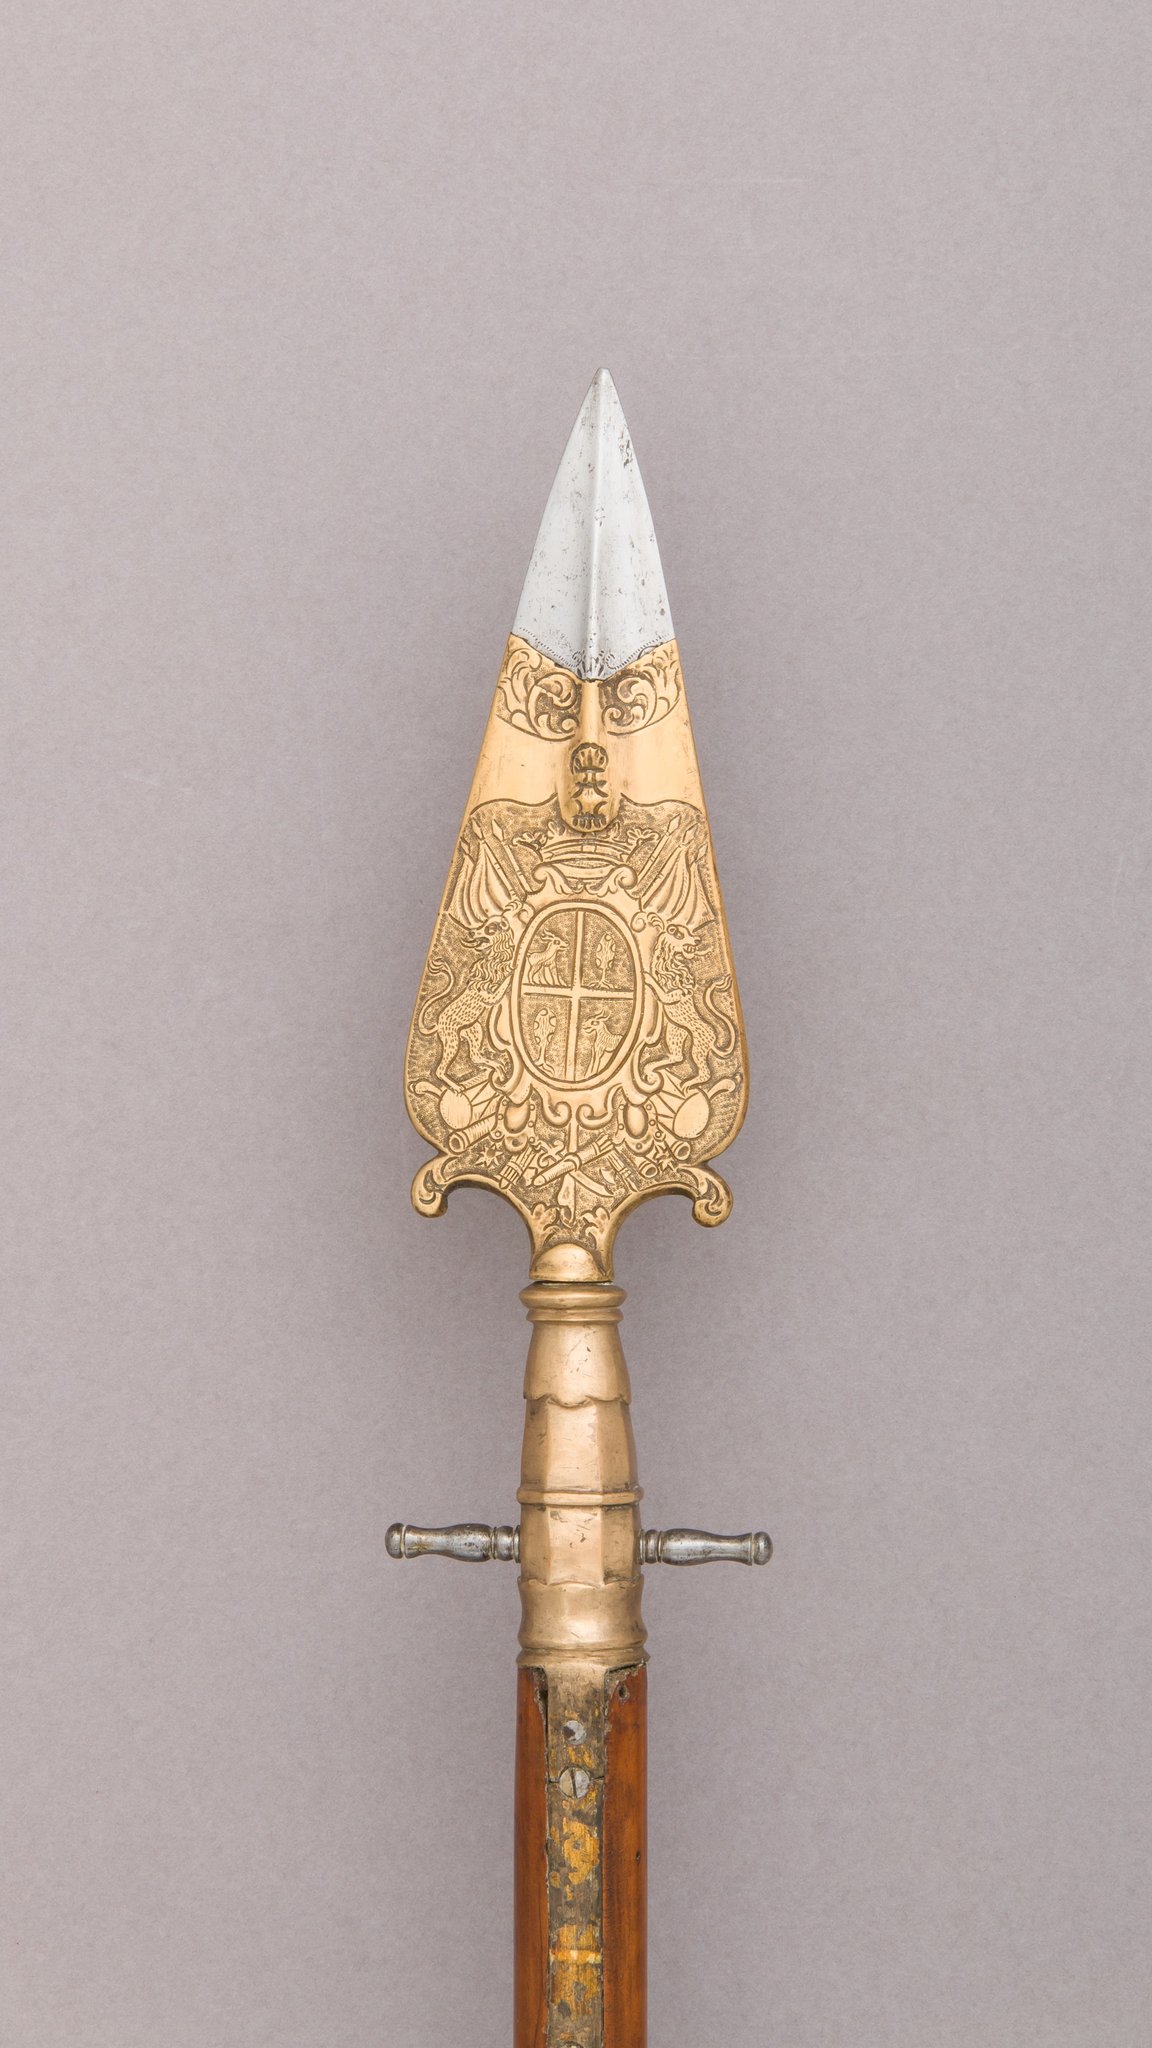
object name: lance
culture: french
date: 1701-1800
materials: gold, steel, wood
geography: france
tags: coat of arms